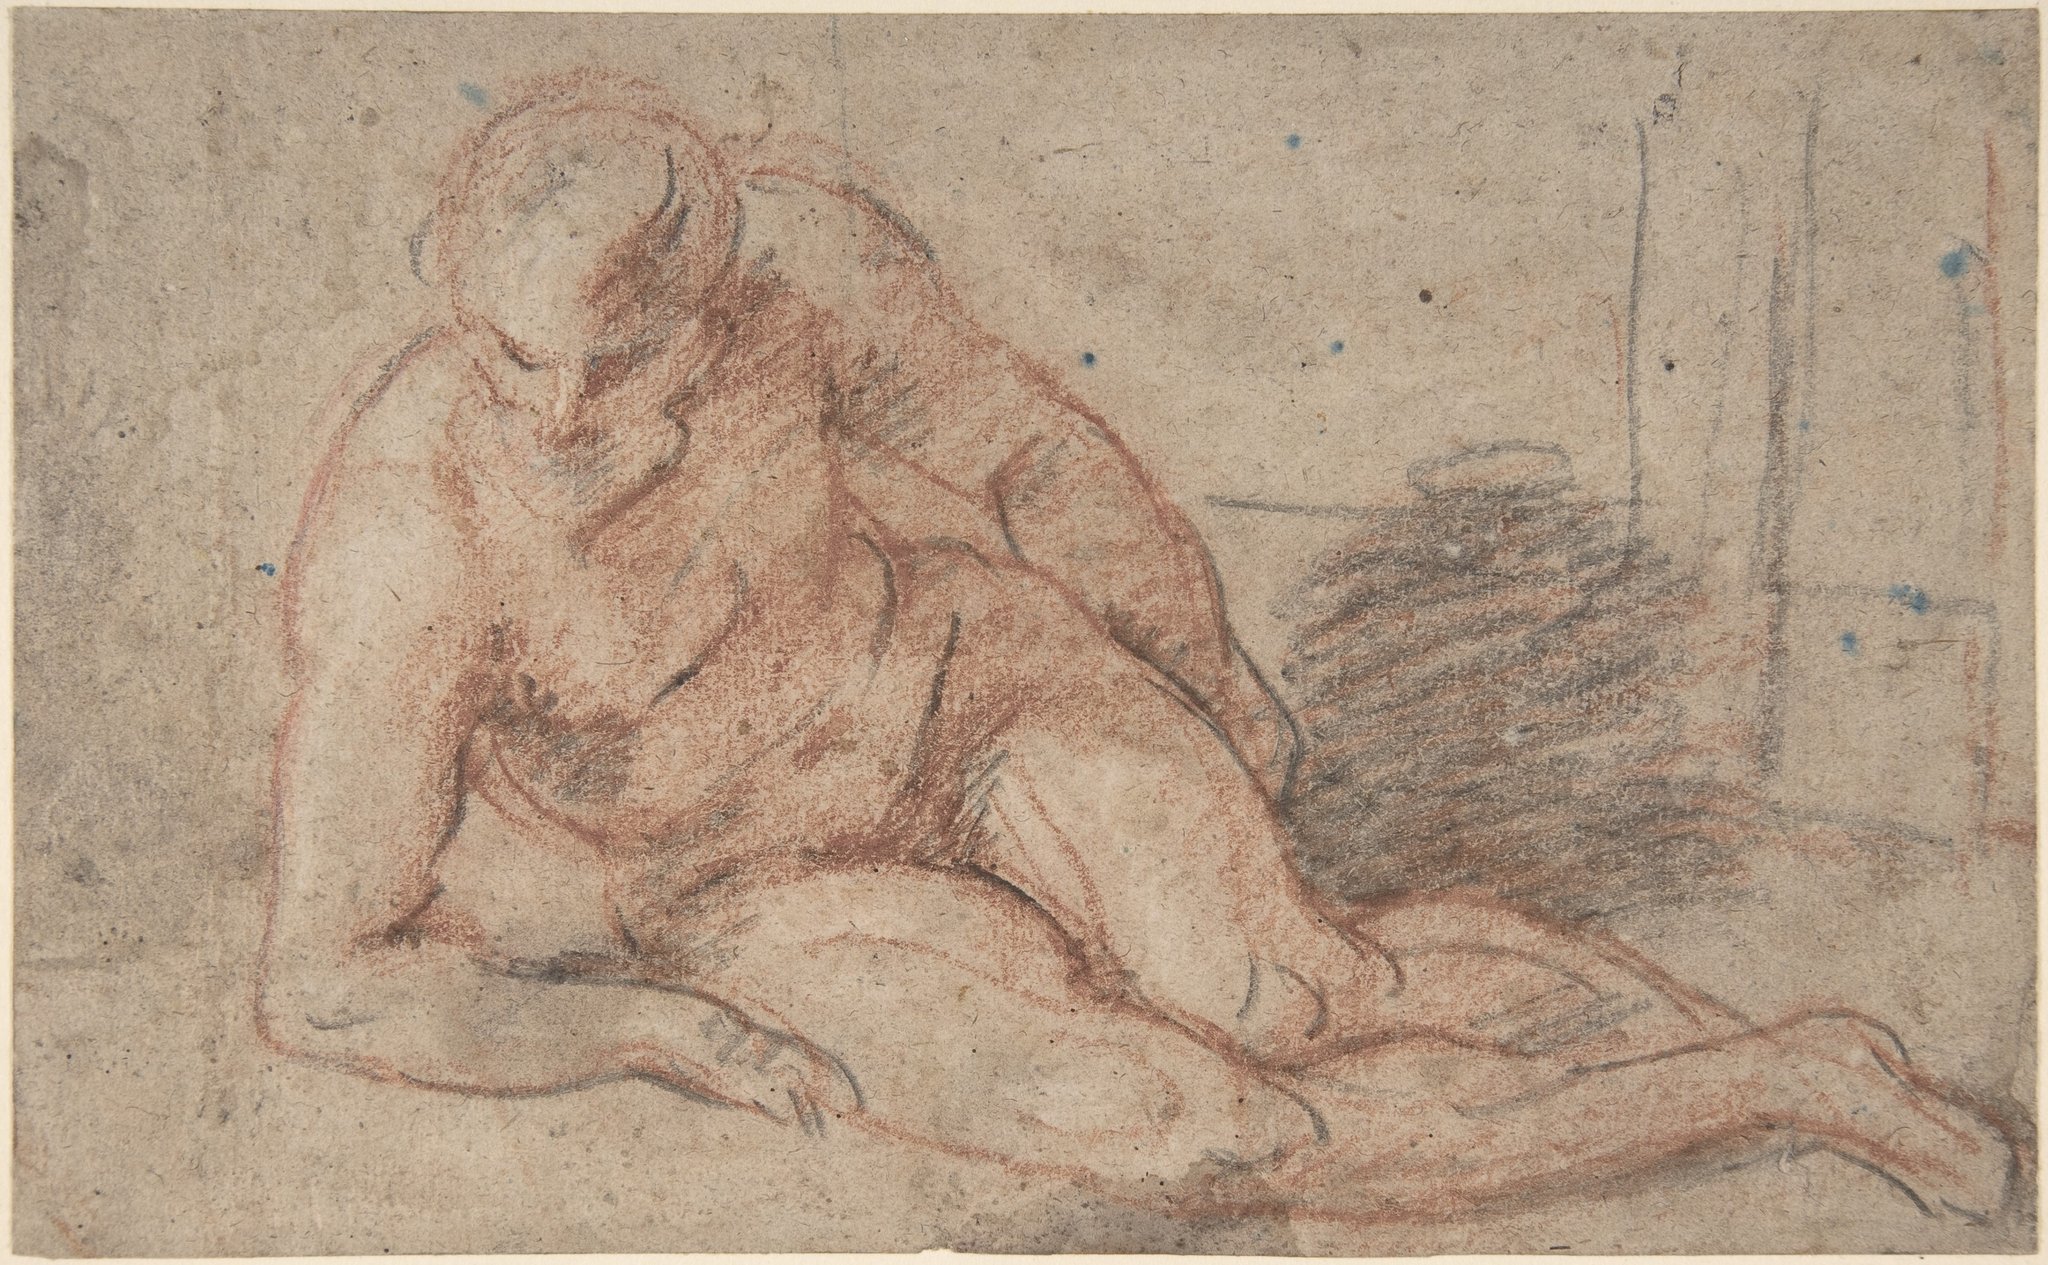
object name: drawing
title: Reclining Nude Figure (recto); unidentifiable sketches (verso)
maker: antoine watteau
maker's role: artist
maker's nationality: french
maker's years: 1684-1721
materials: chalk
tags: male nudes